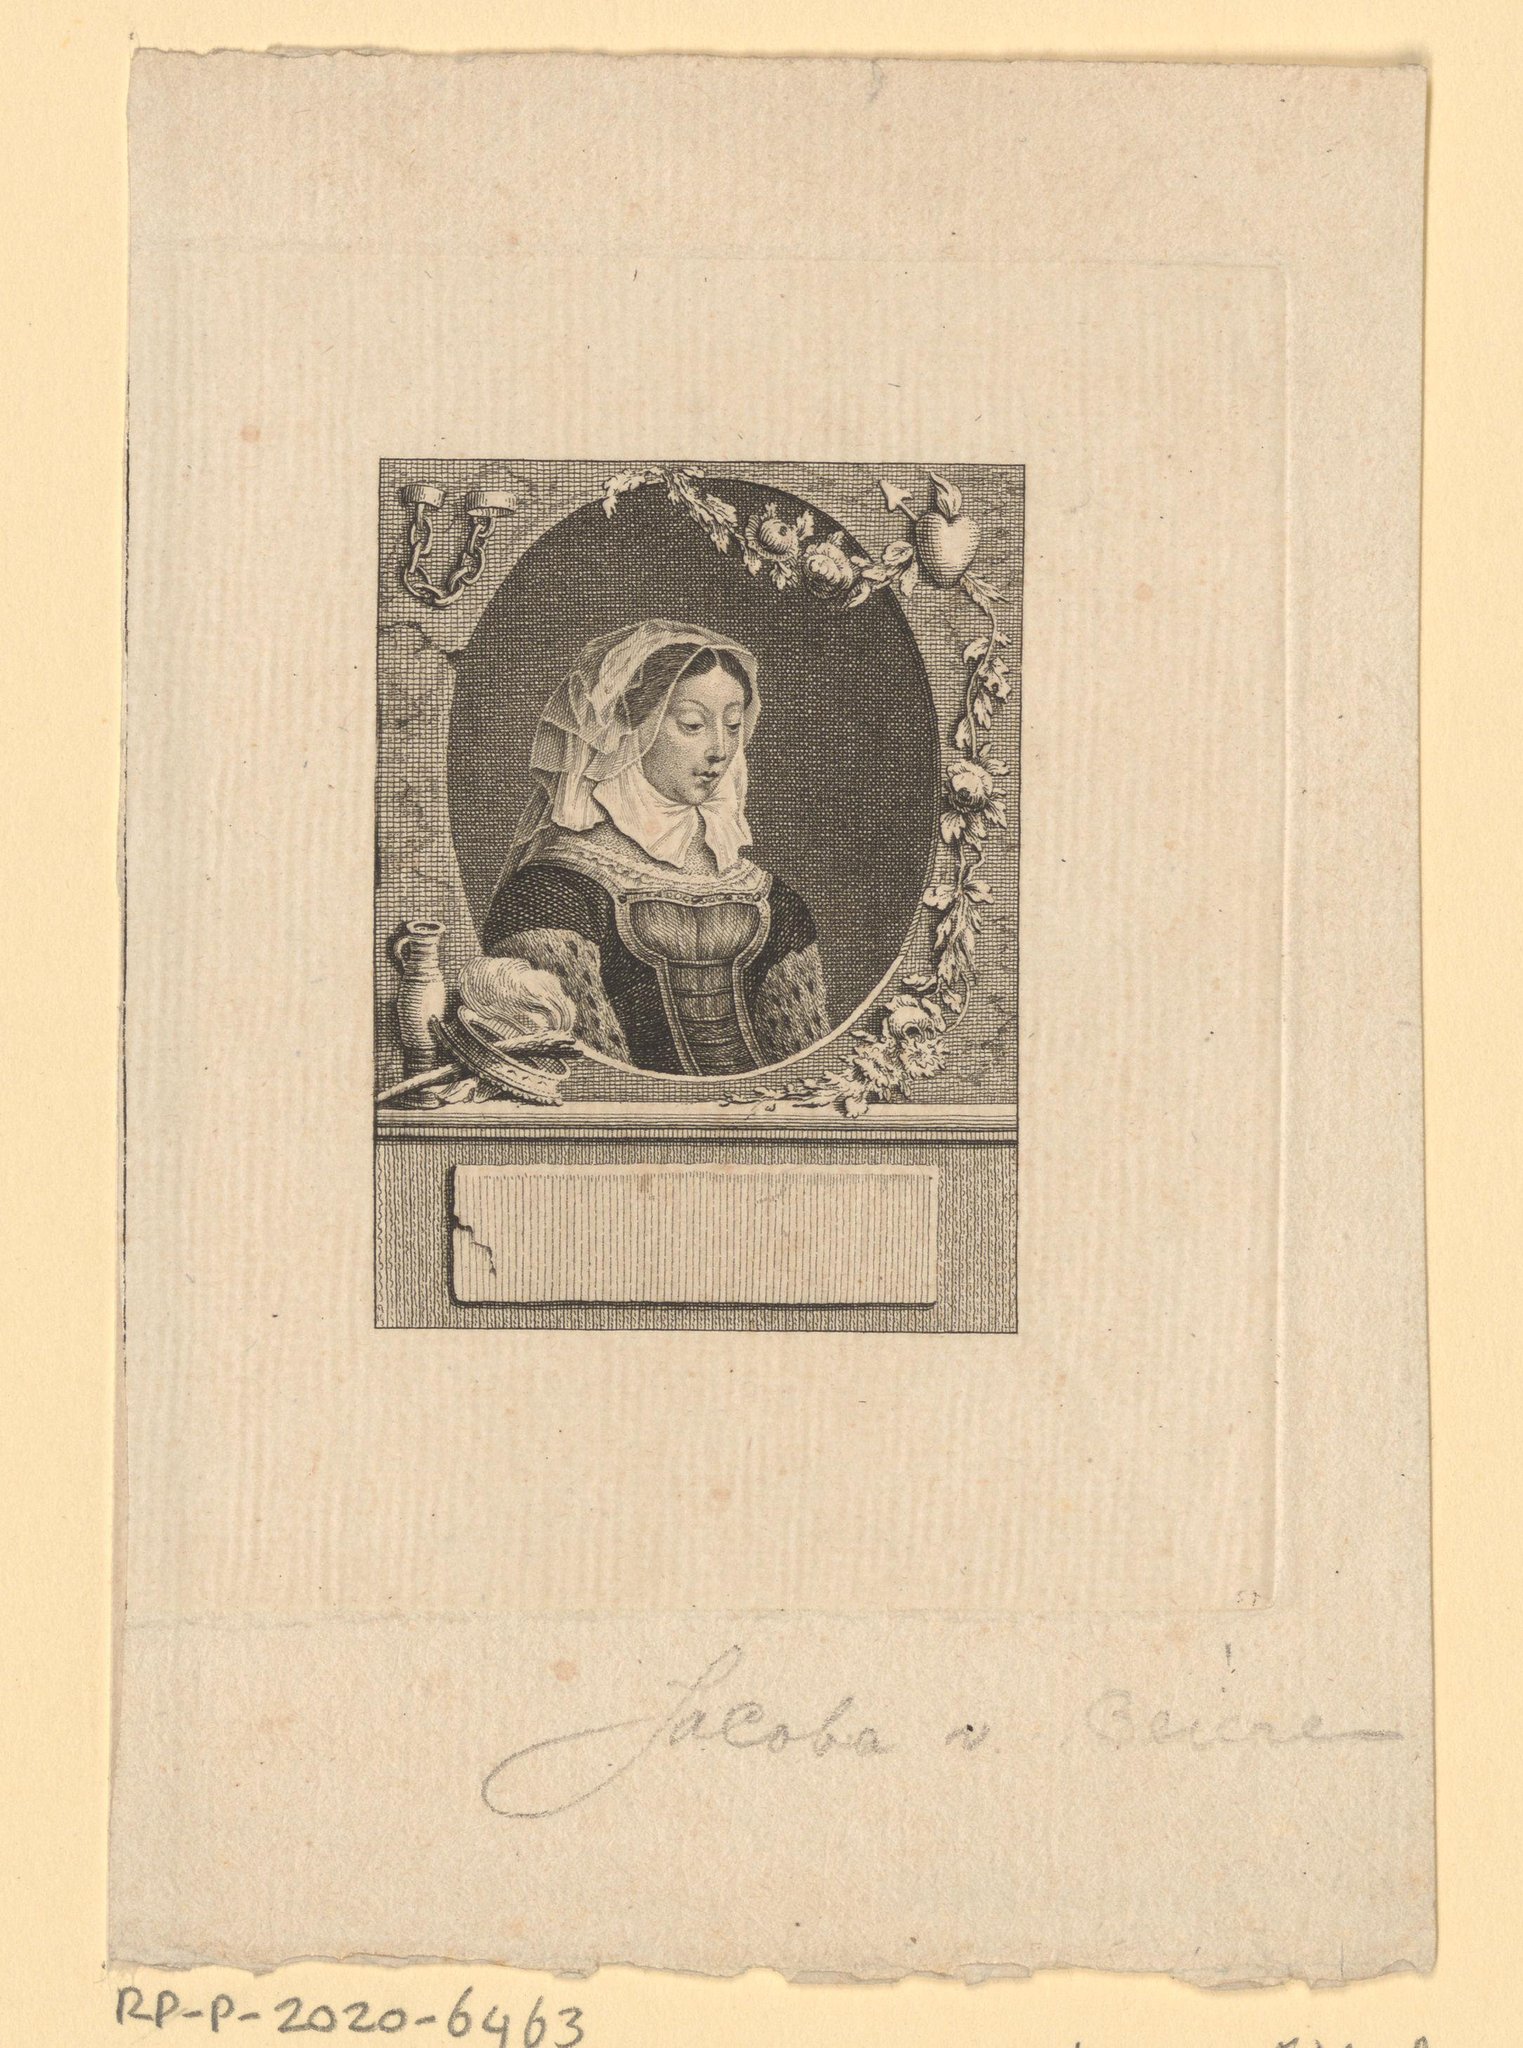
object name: print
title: Portret van Jacoba van Beieren, gravin van Holland, Zeeland en Henegouwen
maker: Anonymous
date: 1750-1799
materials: paper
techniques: etching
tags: jacoba of bavaria (countess of hainaut), historical persons - bb - woman, the sacred heart, ruler, sovereign - bb - female ruler, tools, aids, implements ~ crafts and industries: chain